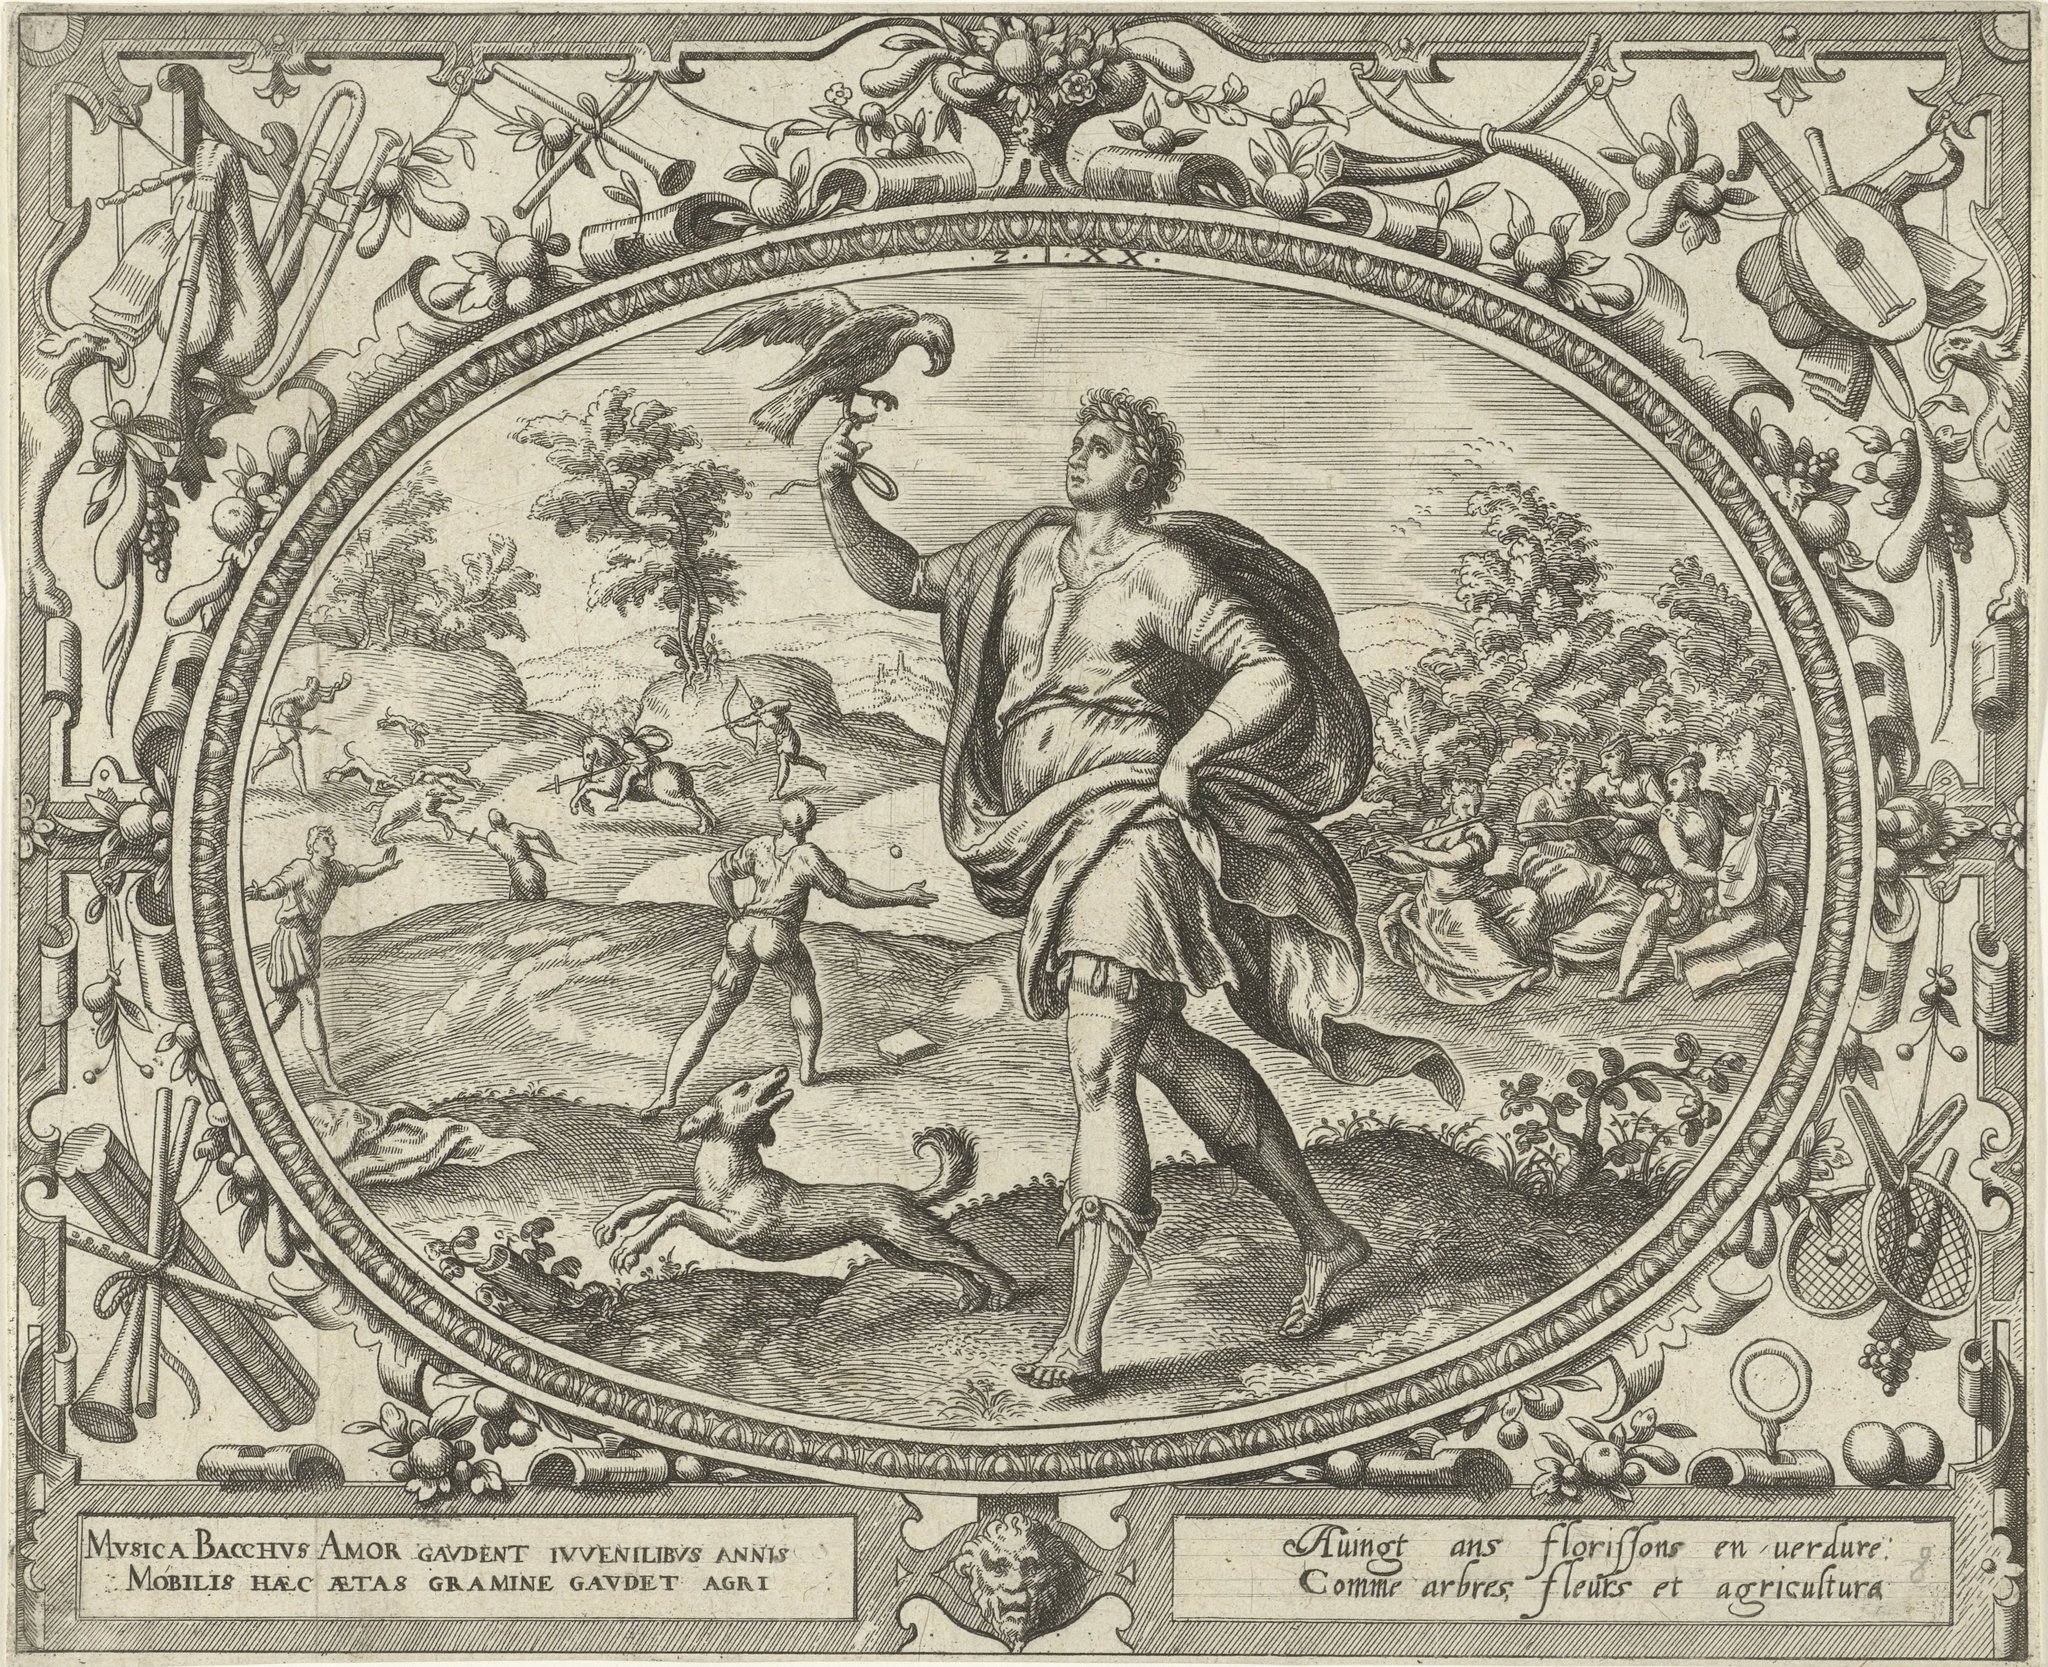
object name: print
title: Tien leeftijden van de mens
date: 1569-1575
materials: paper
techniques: engraving, etching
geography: amsterdam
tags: adolescent, young woman, maiden, more than one musician with instrument, game, hunted animals (+ hunting with falcon, hawk; falconry)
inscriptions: collector's mark: Lugt 2228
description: In een ovaal kader versierd met ornamenten een voorstelling van een jongeman op valkenjacht. Op de achtergrond doen jongens aan de jacht, aan sport en spel. Rechts een groep die muziek maakt. De prent heeft een Latijns onderschrift.